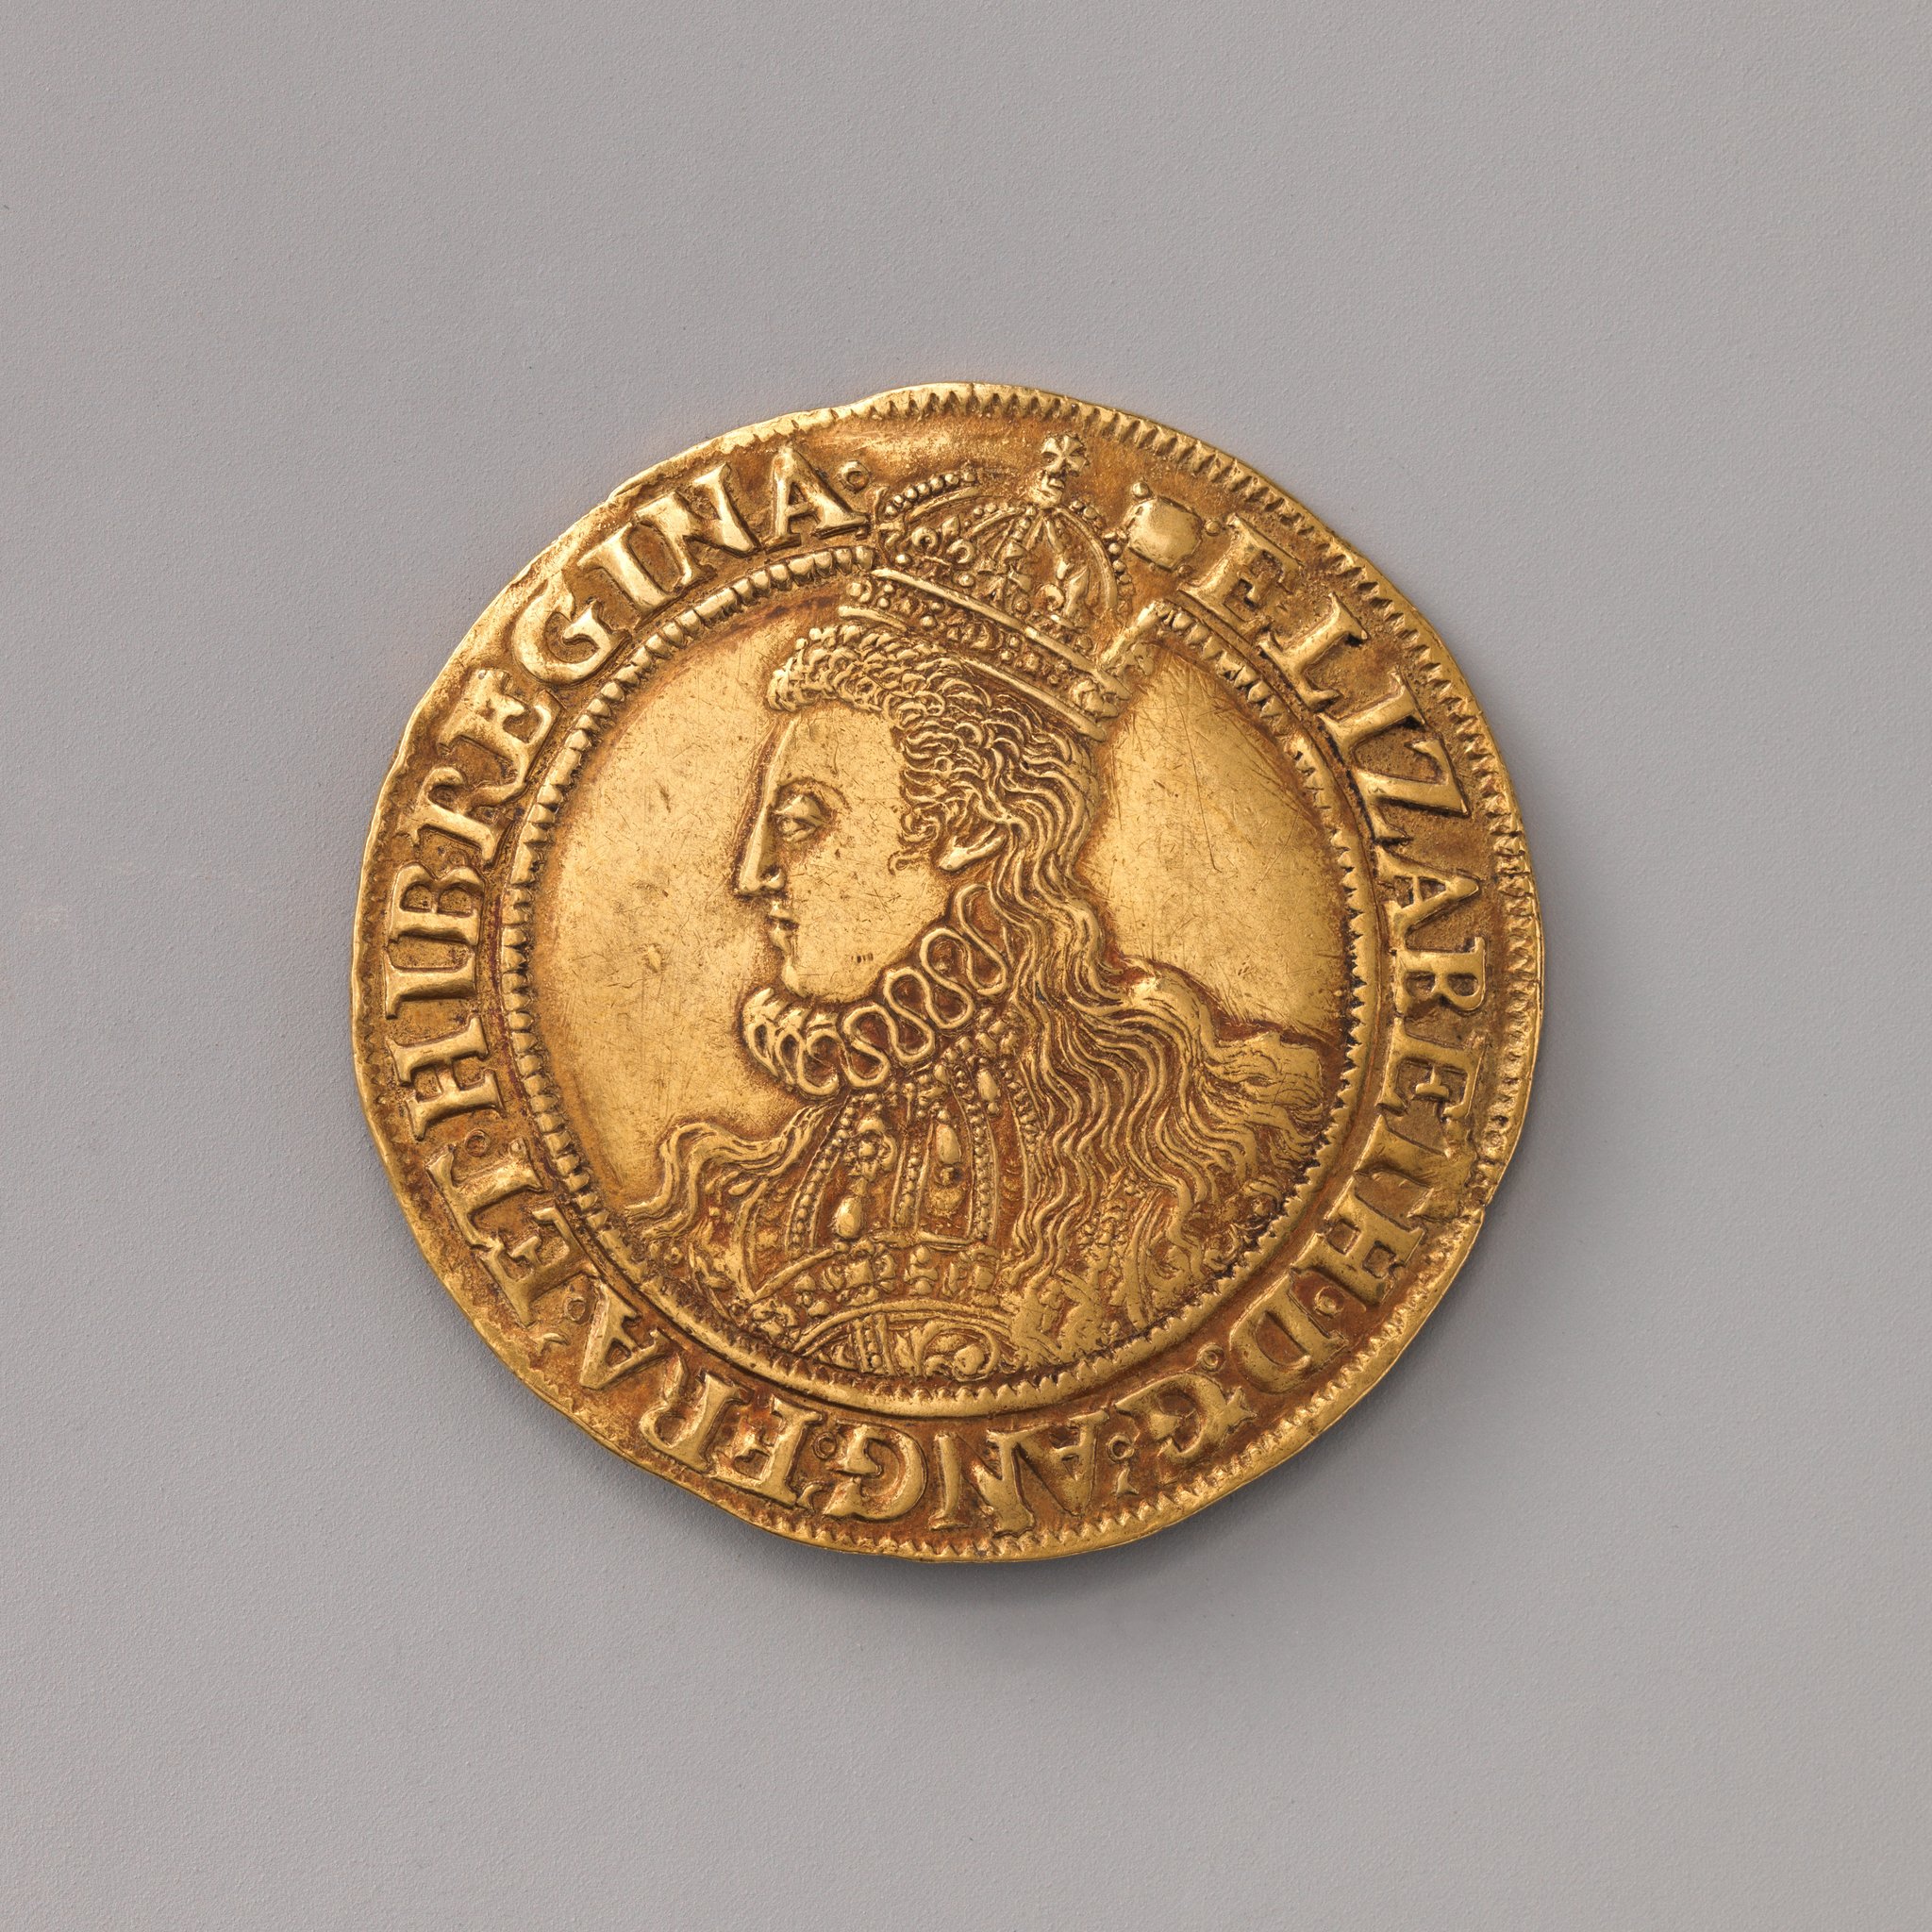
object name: sovereign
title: Elizabeth I (r. 1558–1603)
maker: the royal mint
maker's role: manufactory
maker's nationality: british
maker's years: 886-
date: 1594-1596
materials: gold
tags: elizabeth i,profiles,coins,coat of arms